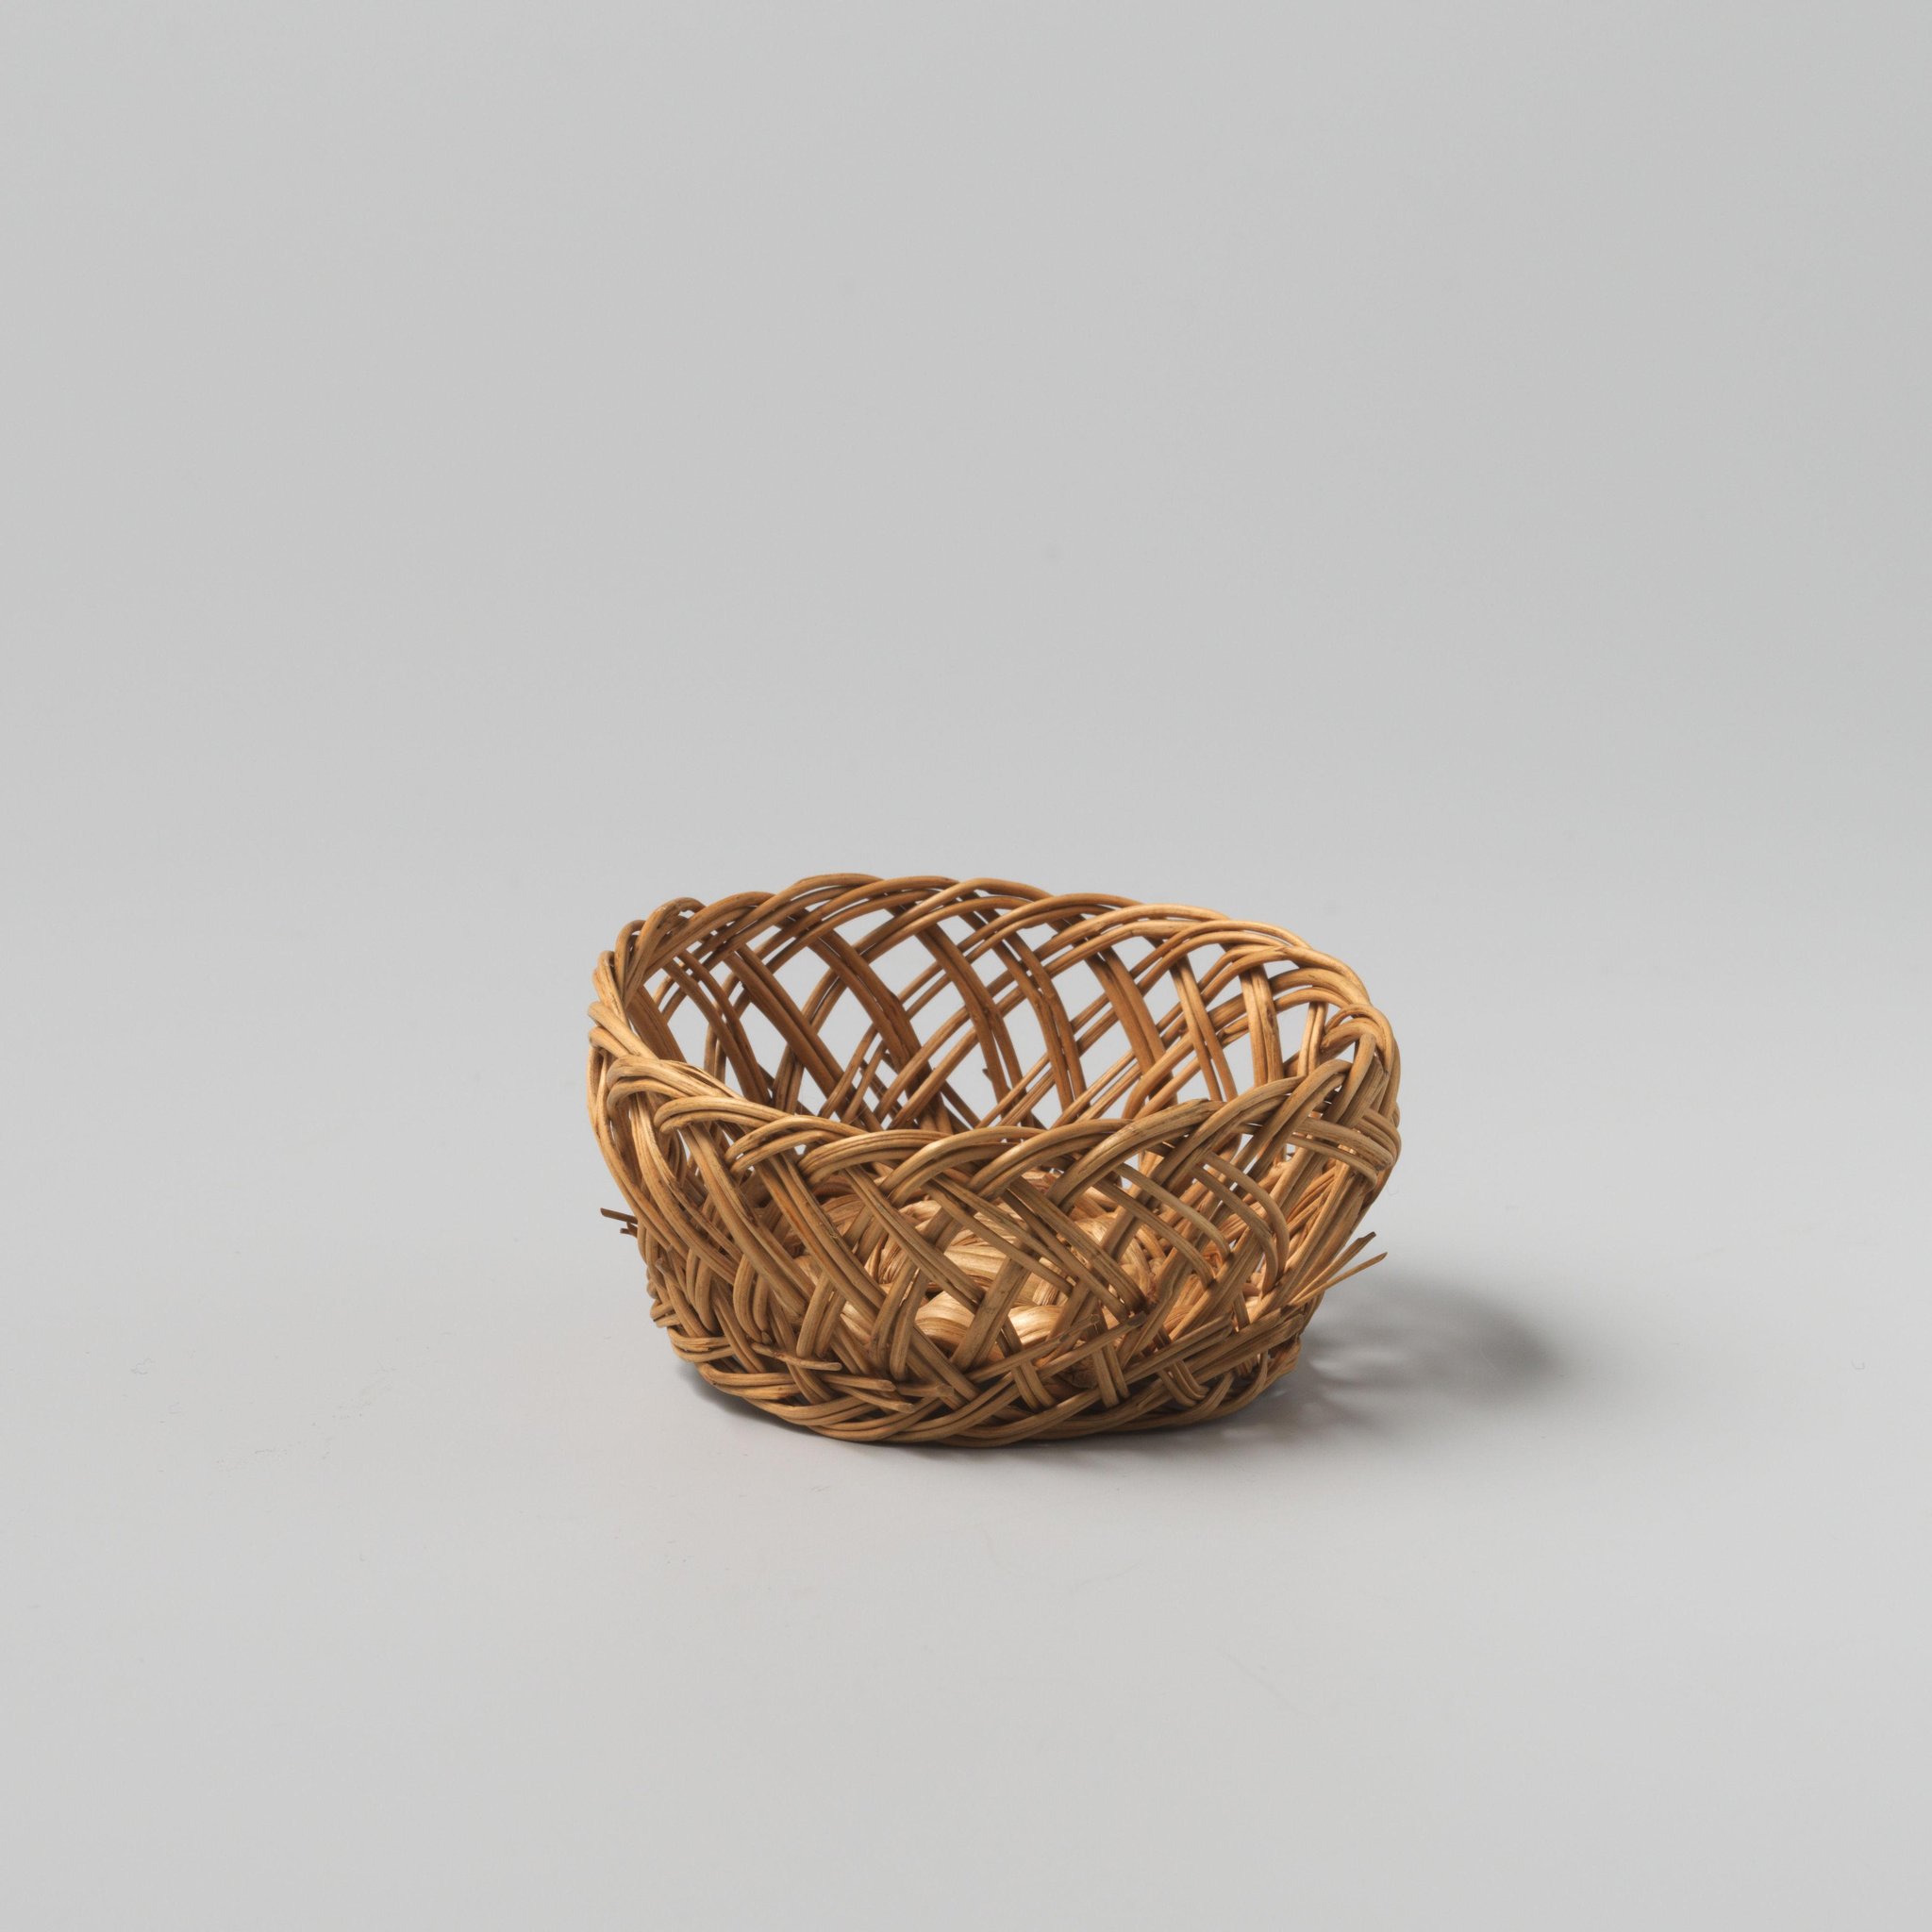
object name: bread basket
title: Broodmand van ronde wilgenteen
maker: Anonymous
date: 1675-1699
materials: plant material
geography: amsterdam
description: Broodmand van ronde wilgenteen, uitgevoerd in zogenaamd open, 'getrokken', vlechtwerk.